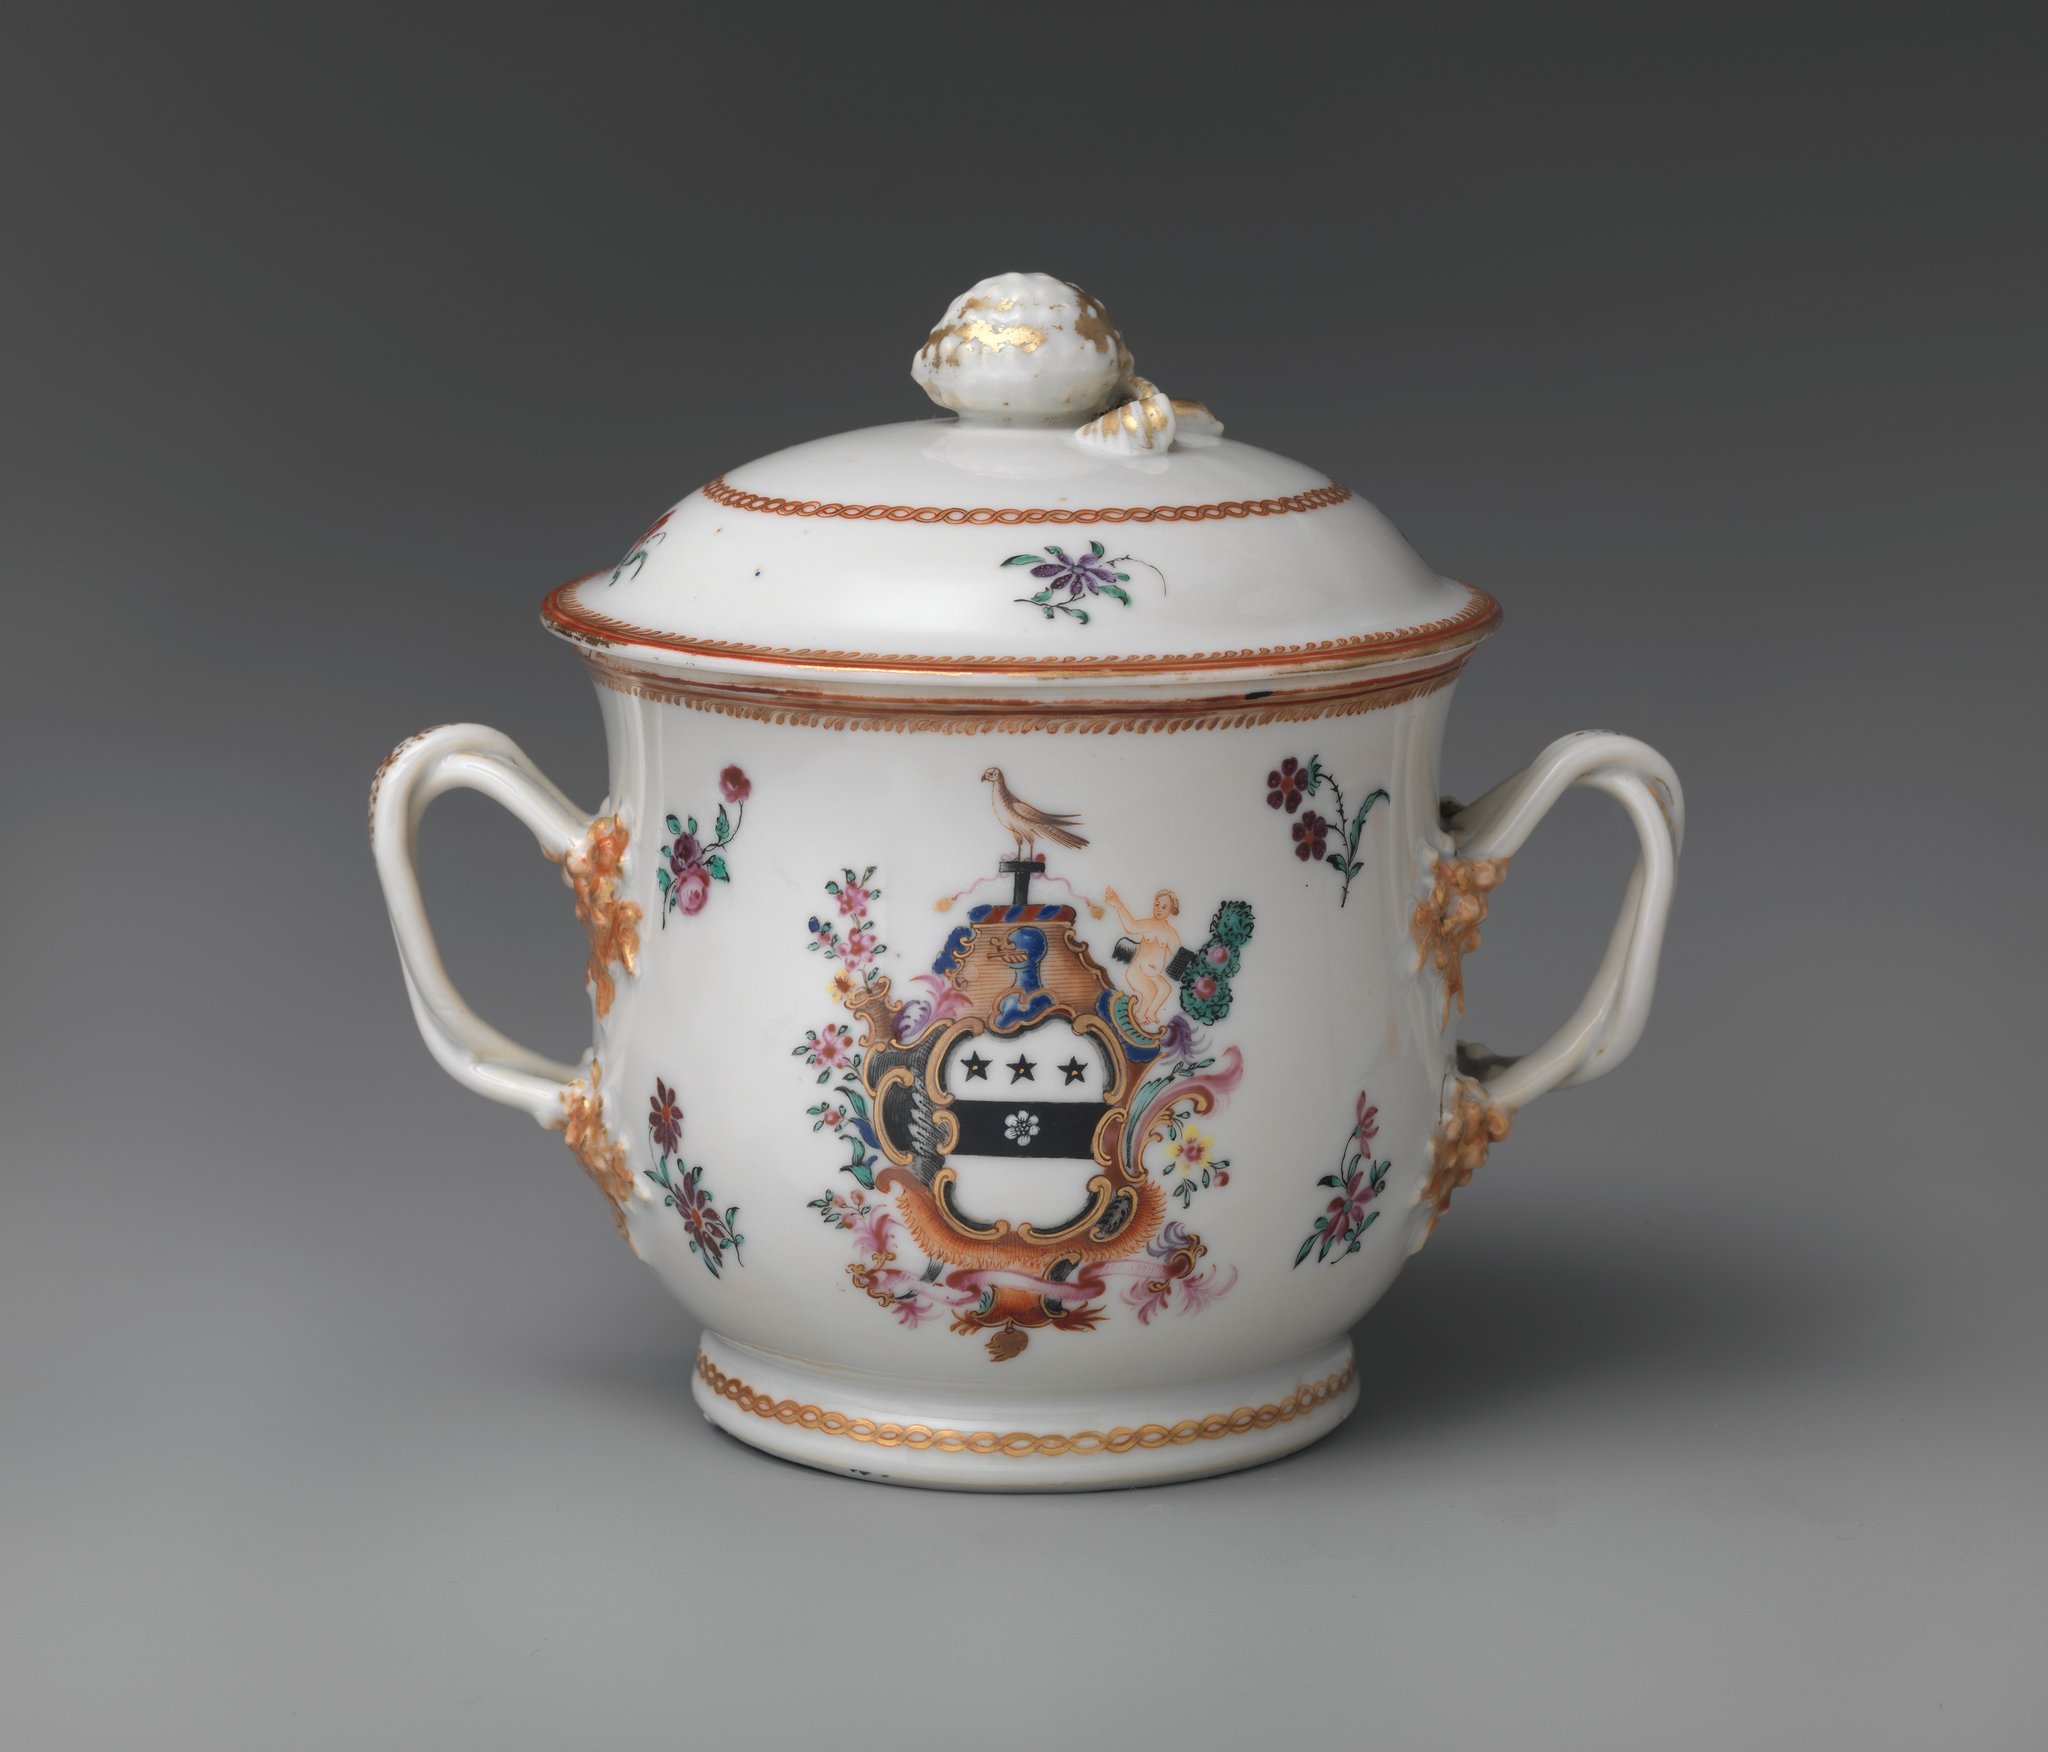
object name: bowl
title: Covered Two-handled Bowl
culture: chinese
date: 1785-1790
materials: porcelain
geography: china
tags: birds,coat of arms